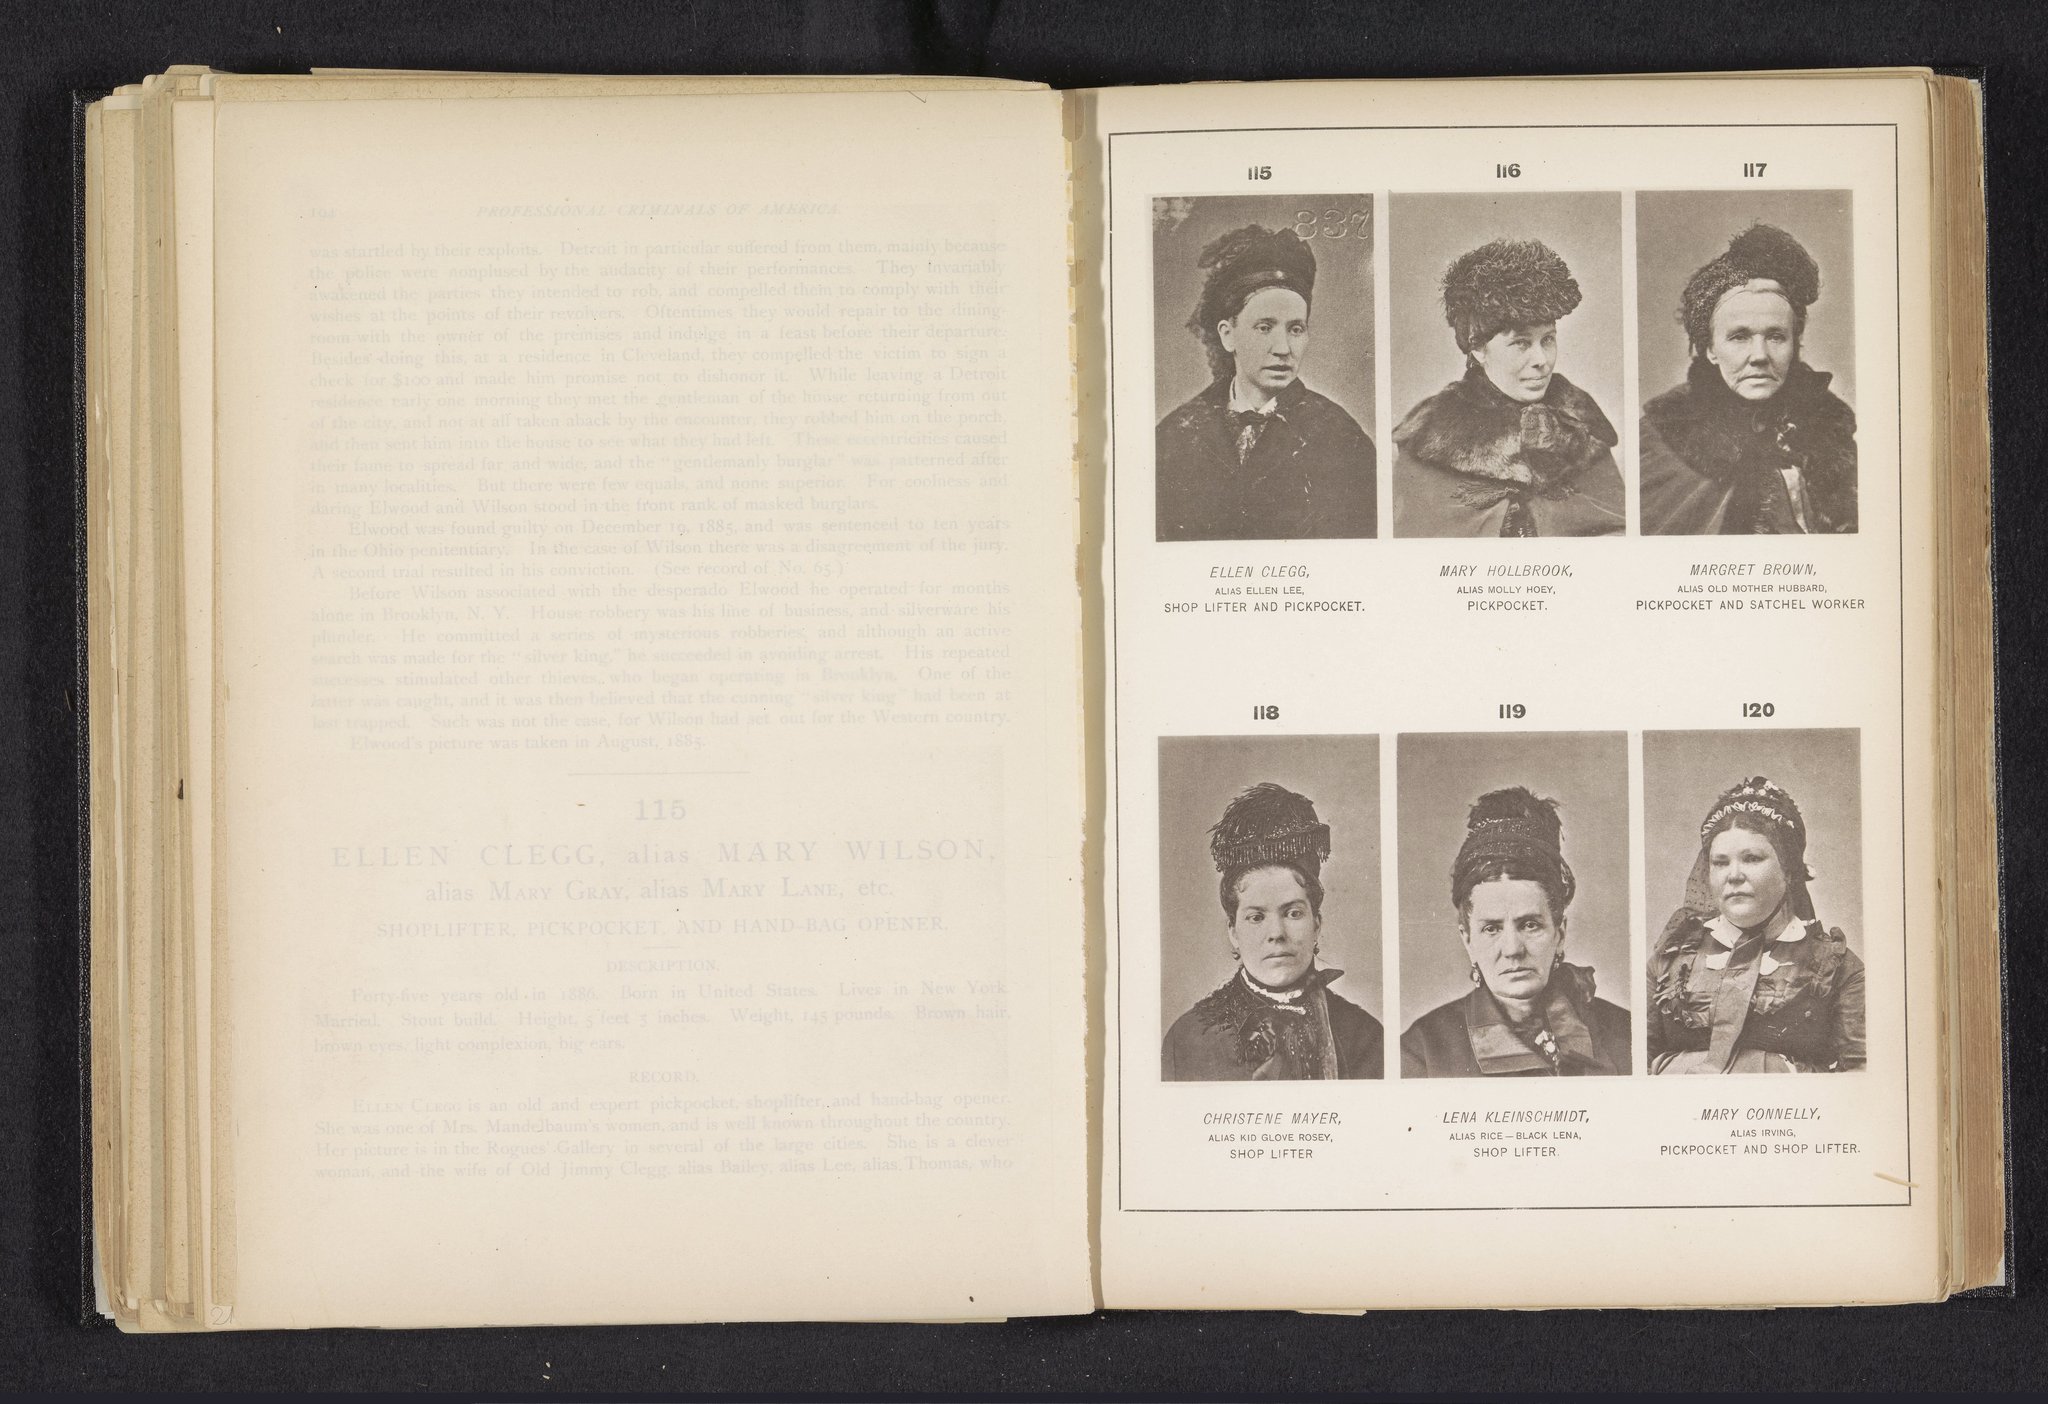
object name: page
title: Zes portretten van vrouwelijke zakkenrollers en winkeldieven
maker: Anonymous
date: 1881-1886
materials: paper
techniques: photograph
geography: boston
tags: historical persons not known by name - bb - woman (+ (full) bust portrait), thief, pickpocket - gg - female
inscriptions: number: ‘115 (...) 120’, inscription: ‘Ellen Clegg (...) pickpocket and shop lifter.’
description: Linksboven Ellen Clegg, midden boven Mary Hollbrook, rechtsboven Margaret Brown, linksonder Christene Mayer, midden onder Lena Kleinschmidt, rechtsonder Mary Connelly.